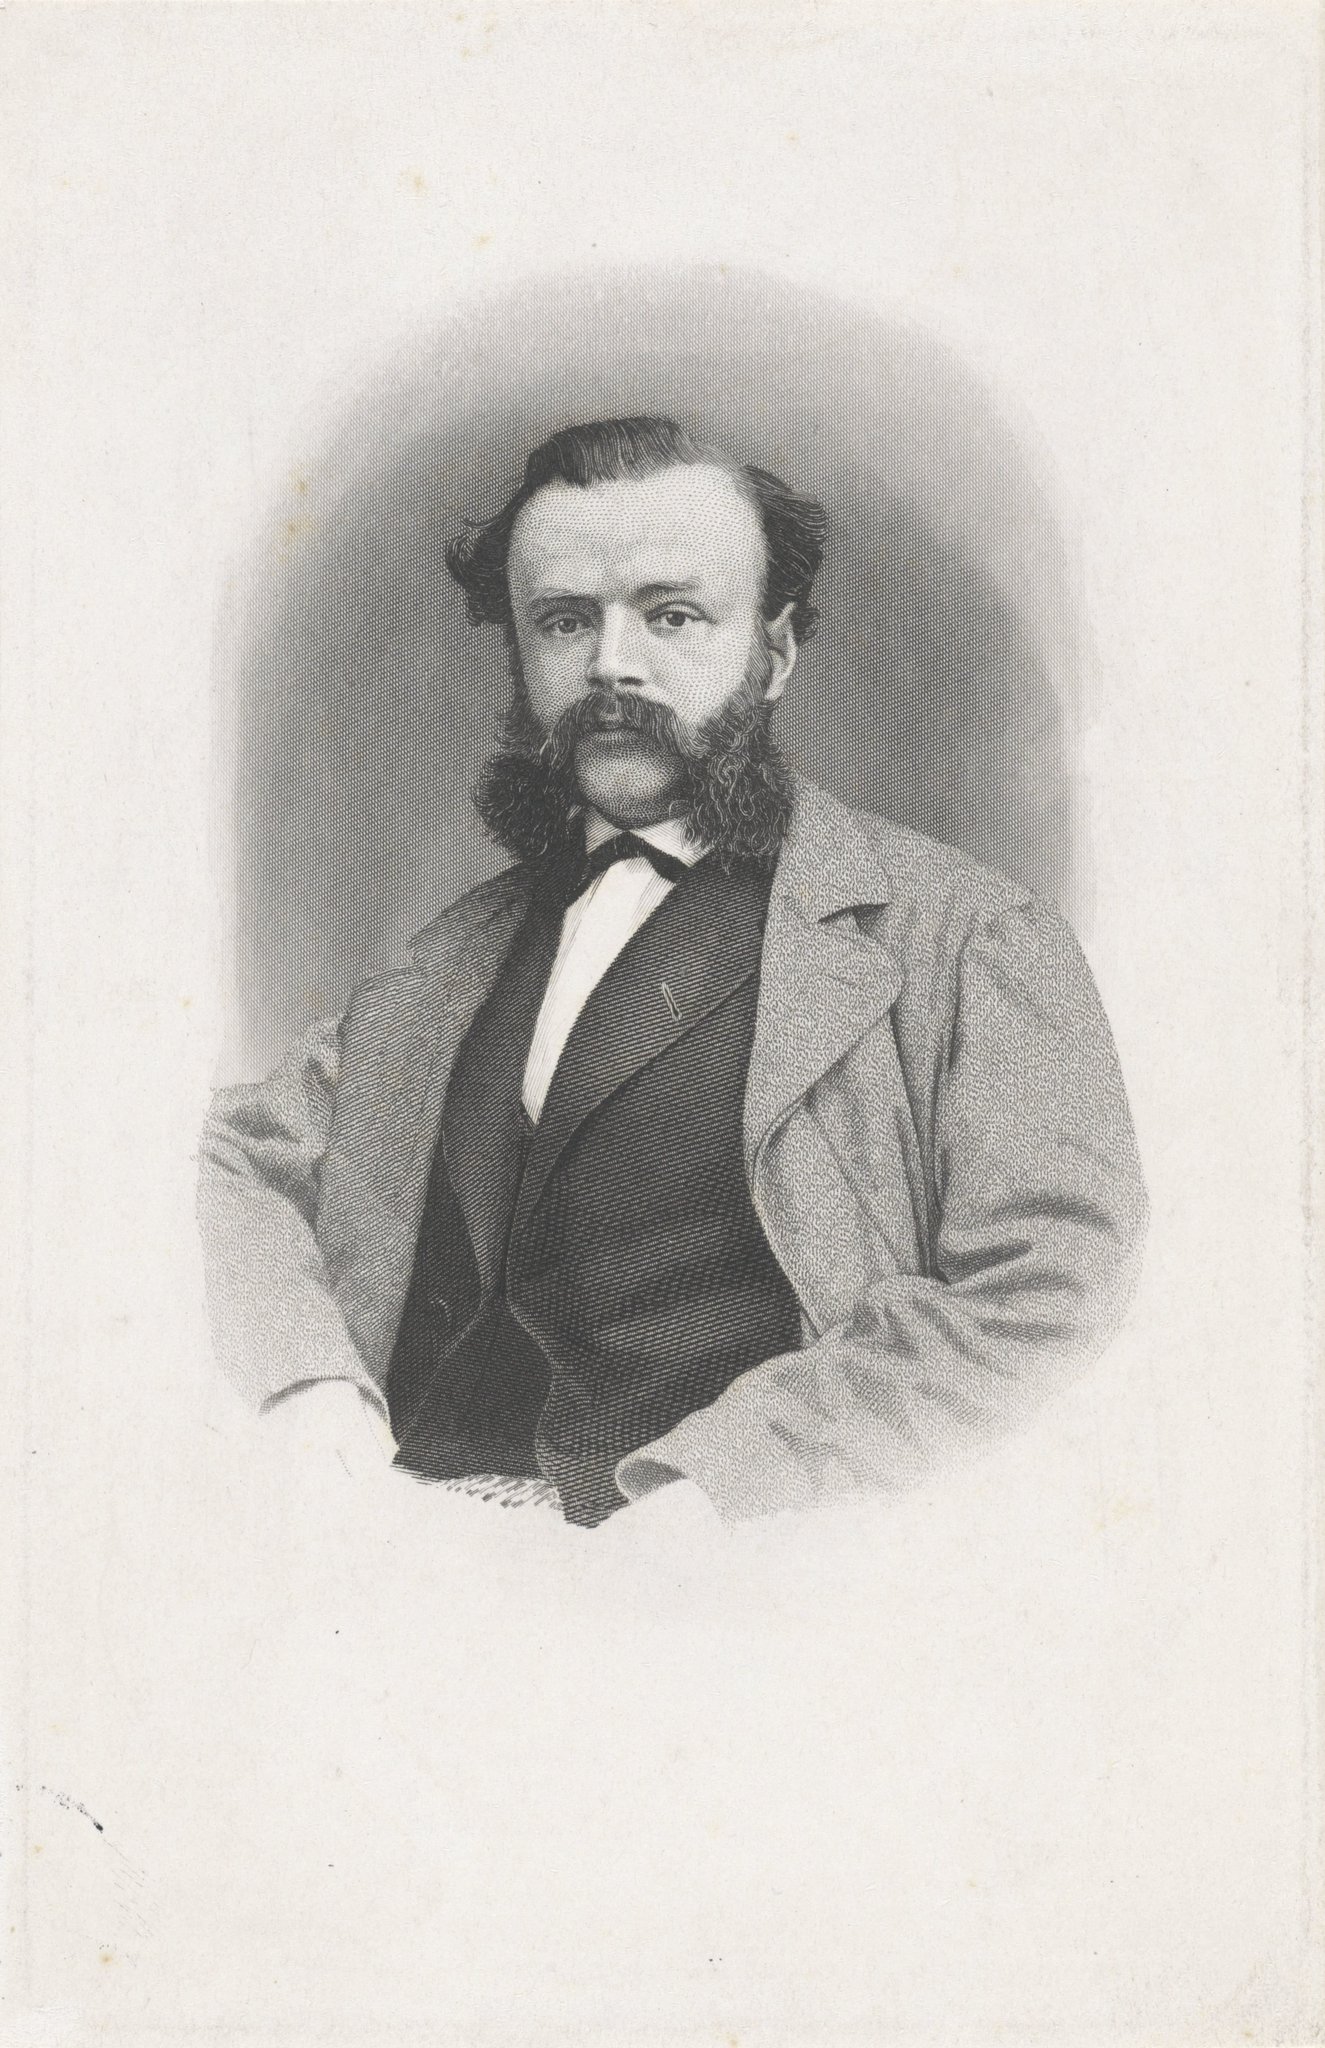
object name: print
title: Portret van Jan ten Brink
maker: dirk jurriaan sluyter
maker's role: draughtsman, print maker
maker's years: 1811-1886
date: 1855-1886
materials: paper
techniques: etching, engraving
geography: amsterdam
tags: leiden, jan ten brink (1834-1901), portrait of a writer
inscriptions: collector's mark: Lugt 2228